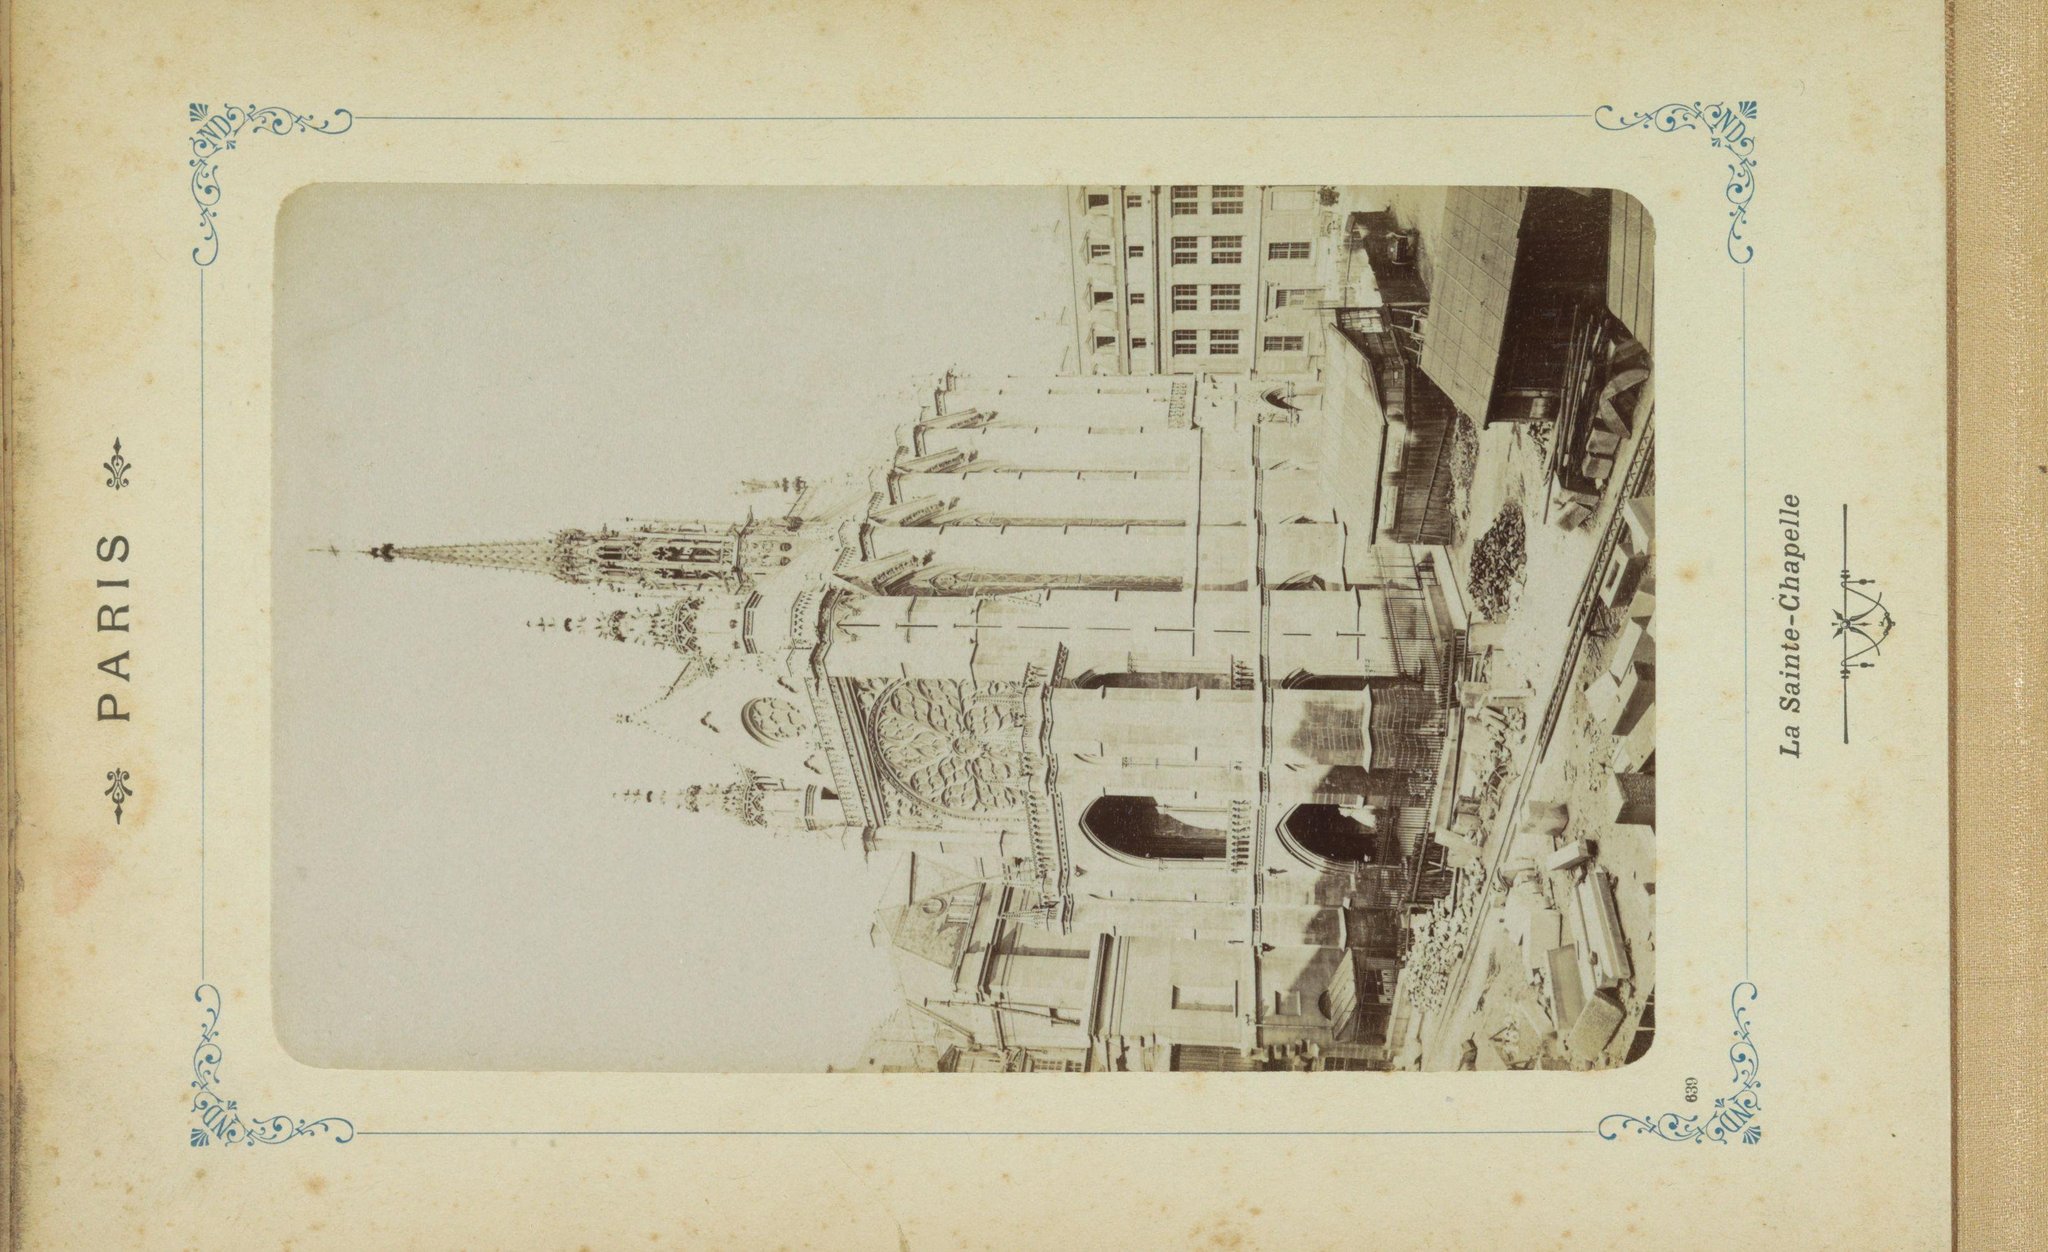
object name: photograph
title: Paris - La Sainte-Chapelle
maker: Anonymous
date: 1900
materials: cardboard, paper, photographic support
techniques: albumen print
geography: paris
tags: church (exterior), paris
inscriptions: number: ‘639’, number: ‘1825’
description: Onderdeel van Fotoalbum met bezienswaardigheden in Parijs, Versailles en het Bois de Boulogne.